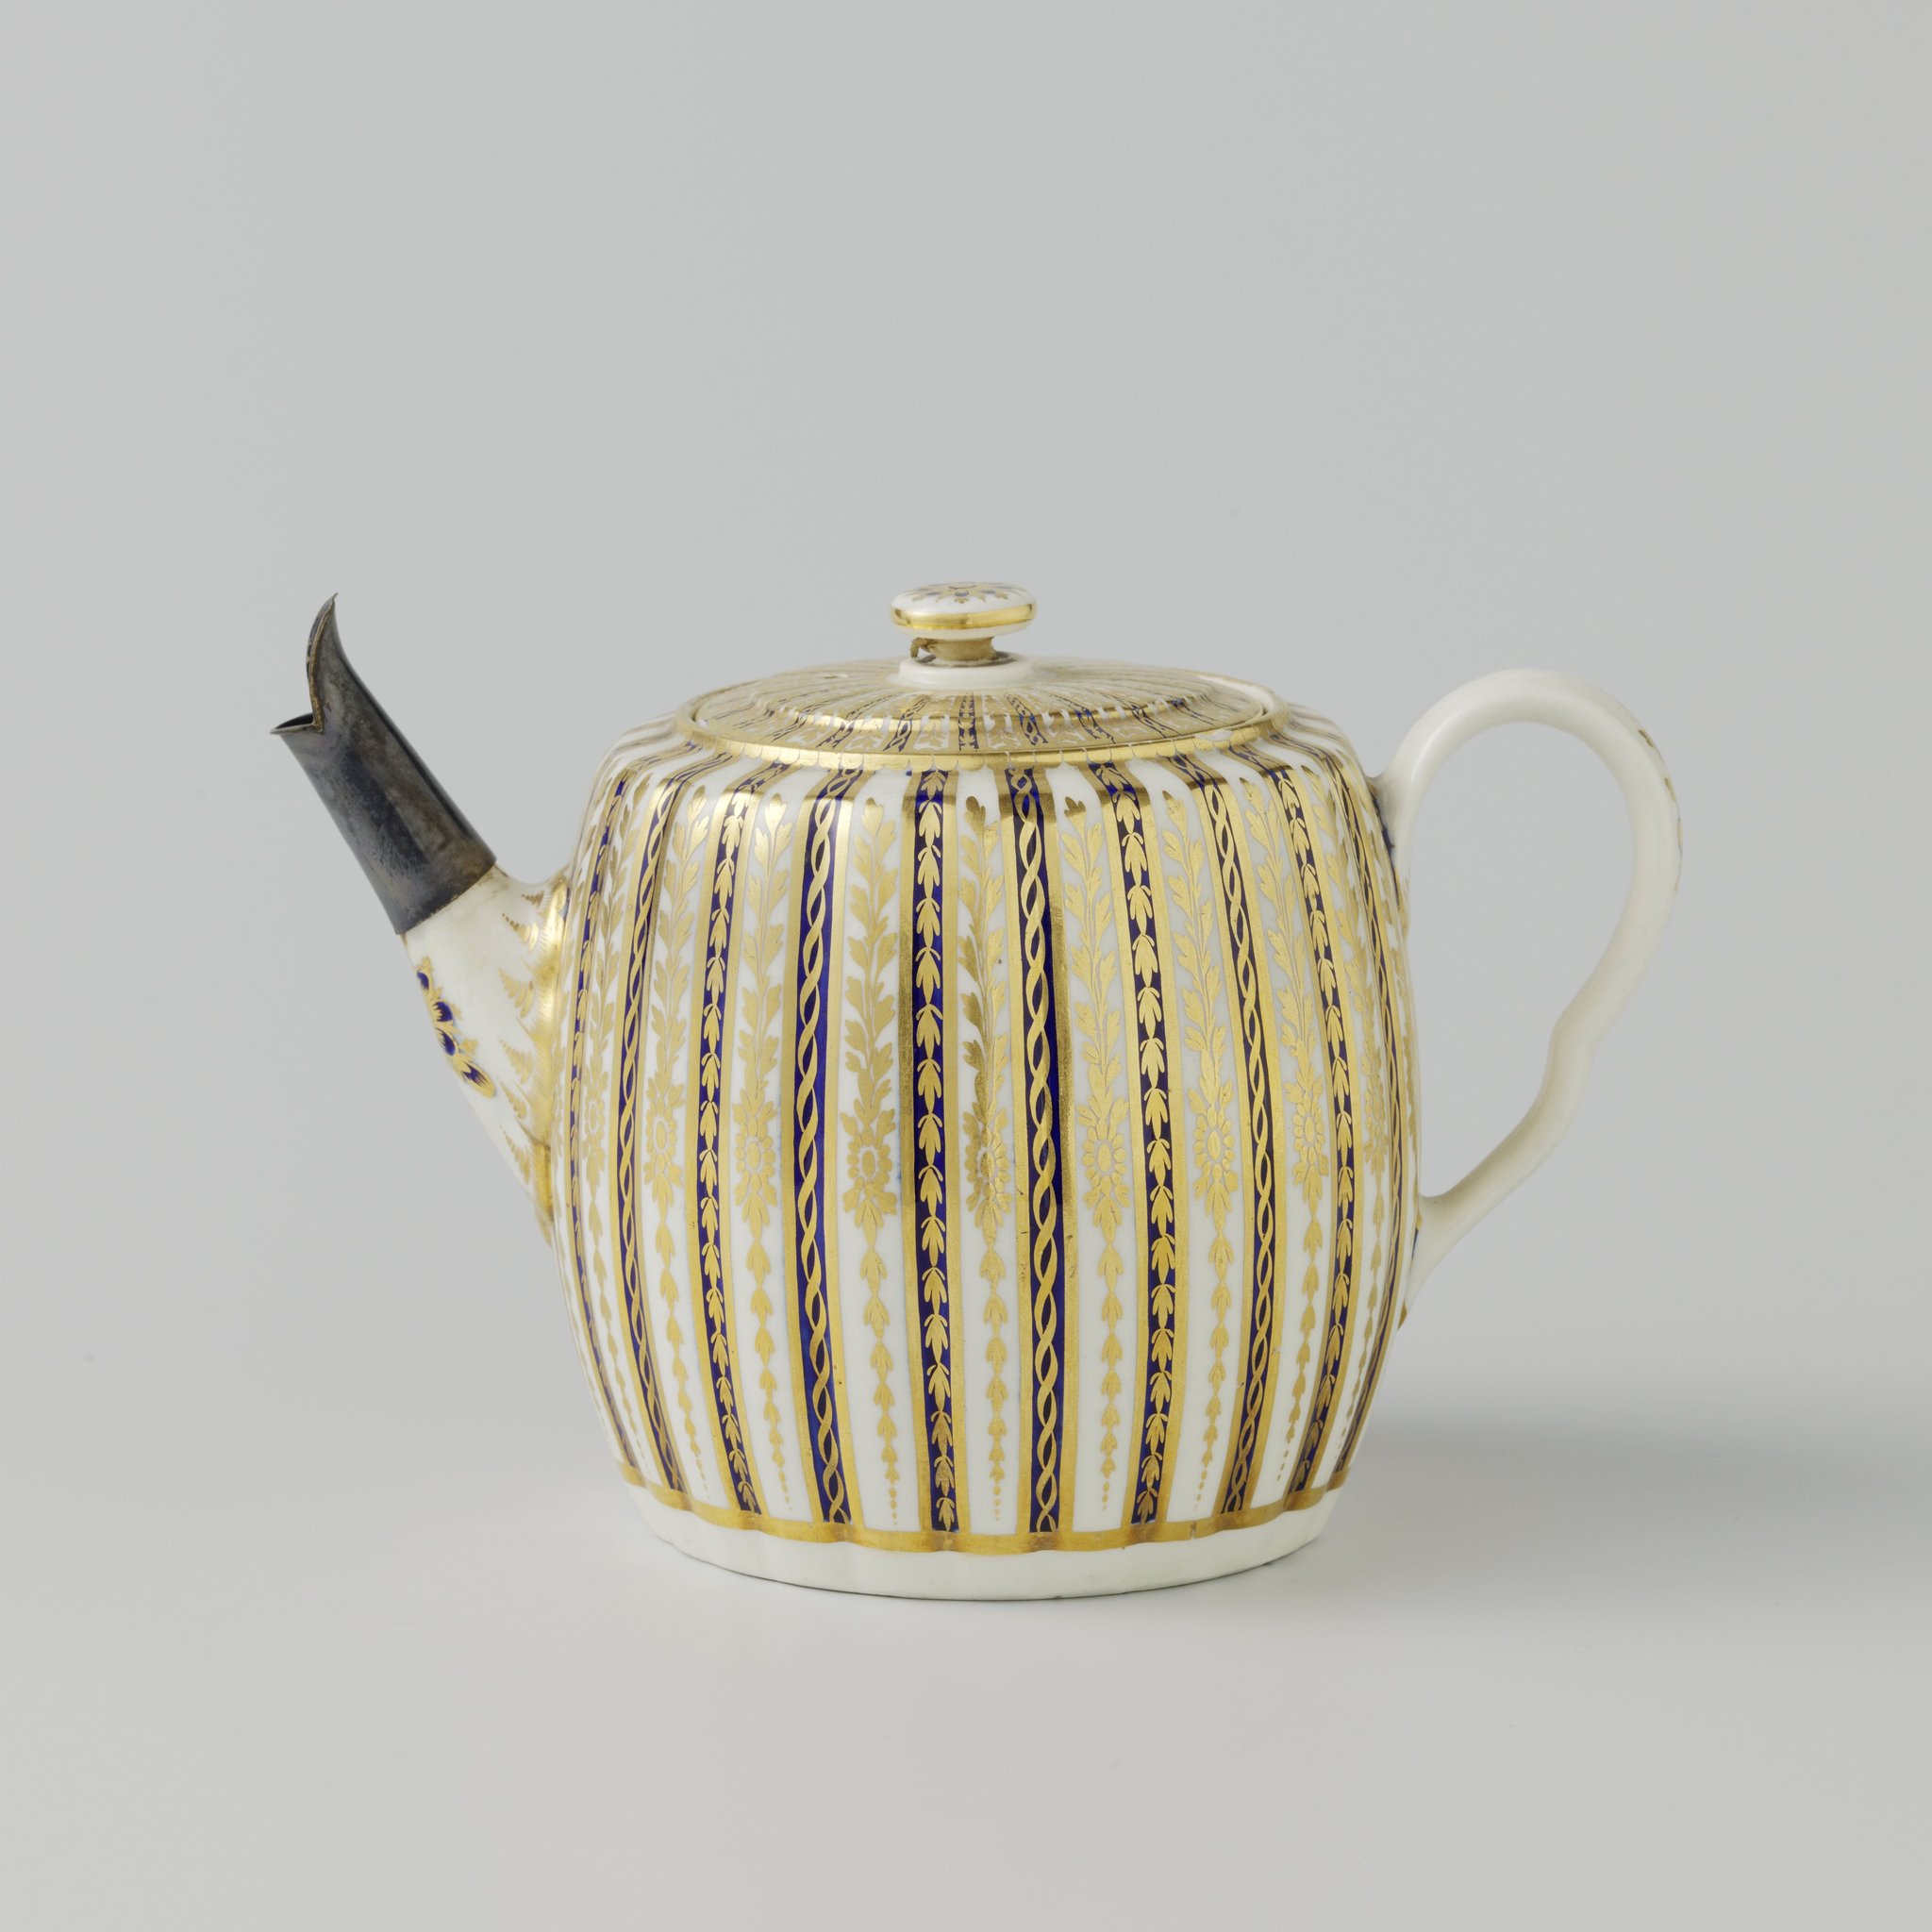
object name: teapot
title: Theepot, de ribben afwisselend blauw en wit, gescheiden door gouden biezen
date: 1775-1800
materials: earthenware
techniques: vitrification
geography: worcester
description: Theepot met deksel. Geribd, de randen gekarteld. De ribben door verticale gouden biezen gescheiden. De holtes donkerblauw (Blue du Roi), de ribben wit, waarop een versiering van bladwerk en vlechtband. Het oor eenmaal geknikt. De randen verguld, verguldsel naar binnen gekarteld. De tuit van de trekpot is beschadigd en met zilver gemonteerd. Gemerkt in onderglazuurblauw.